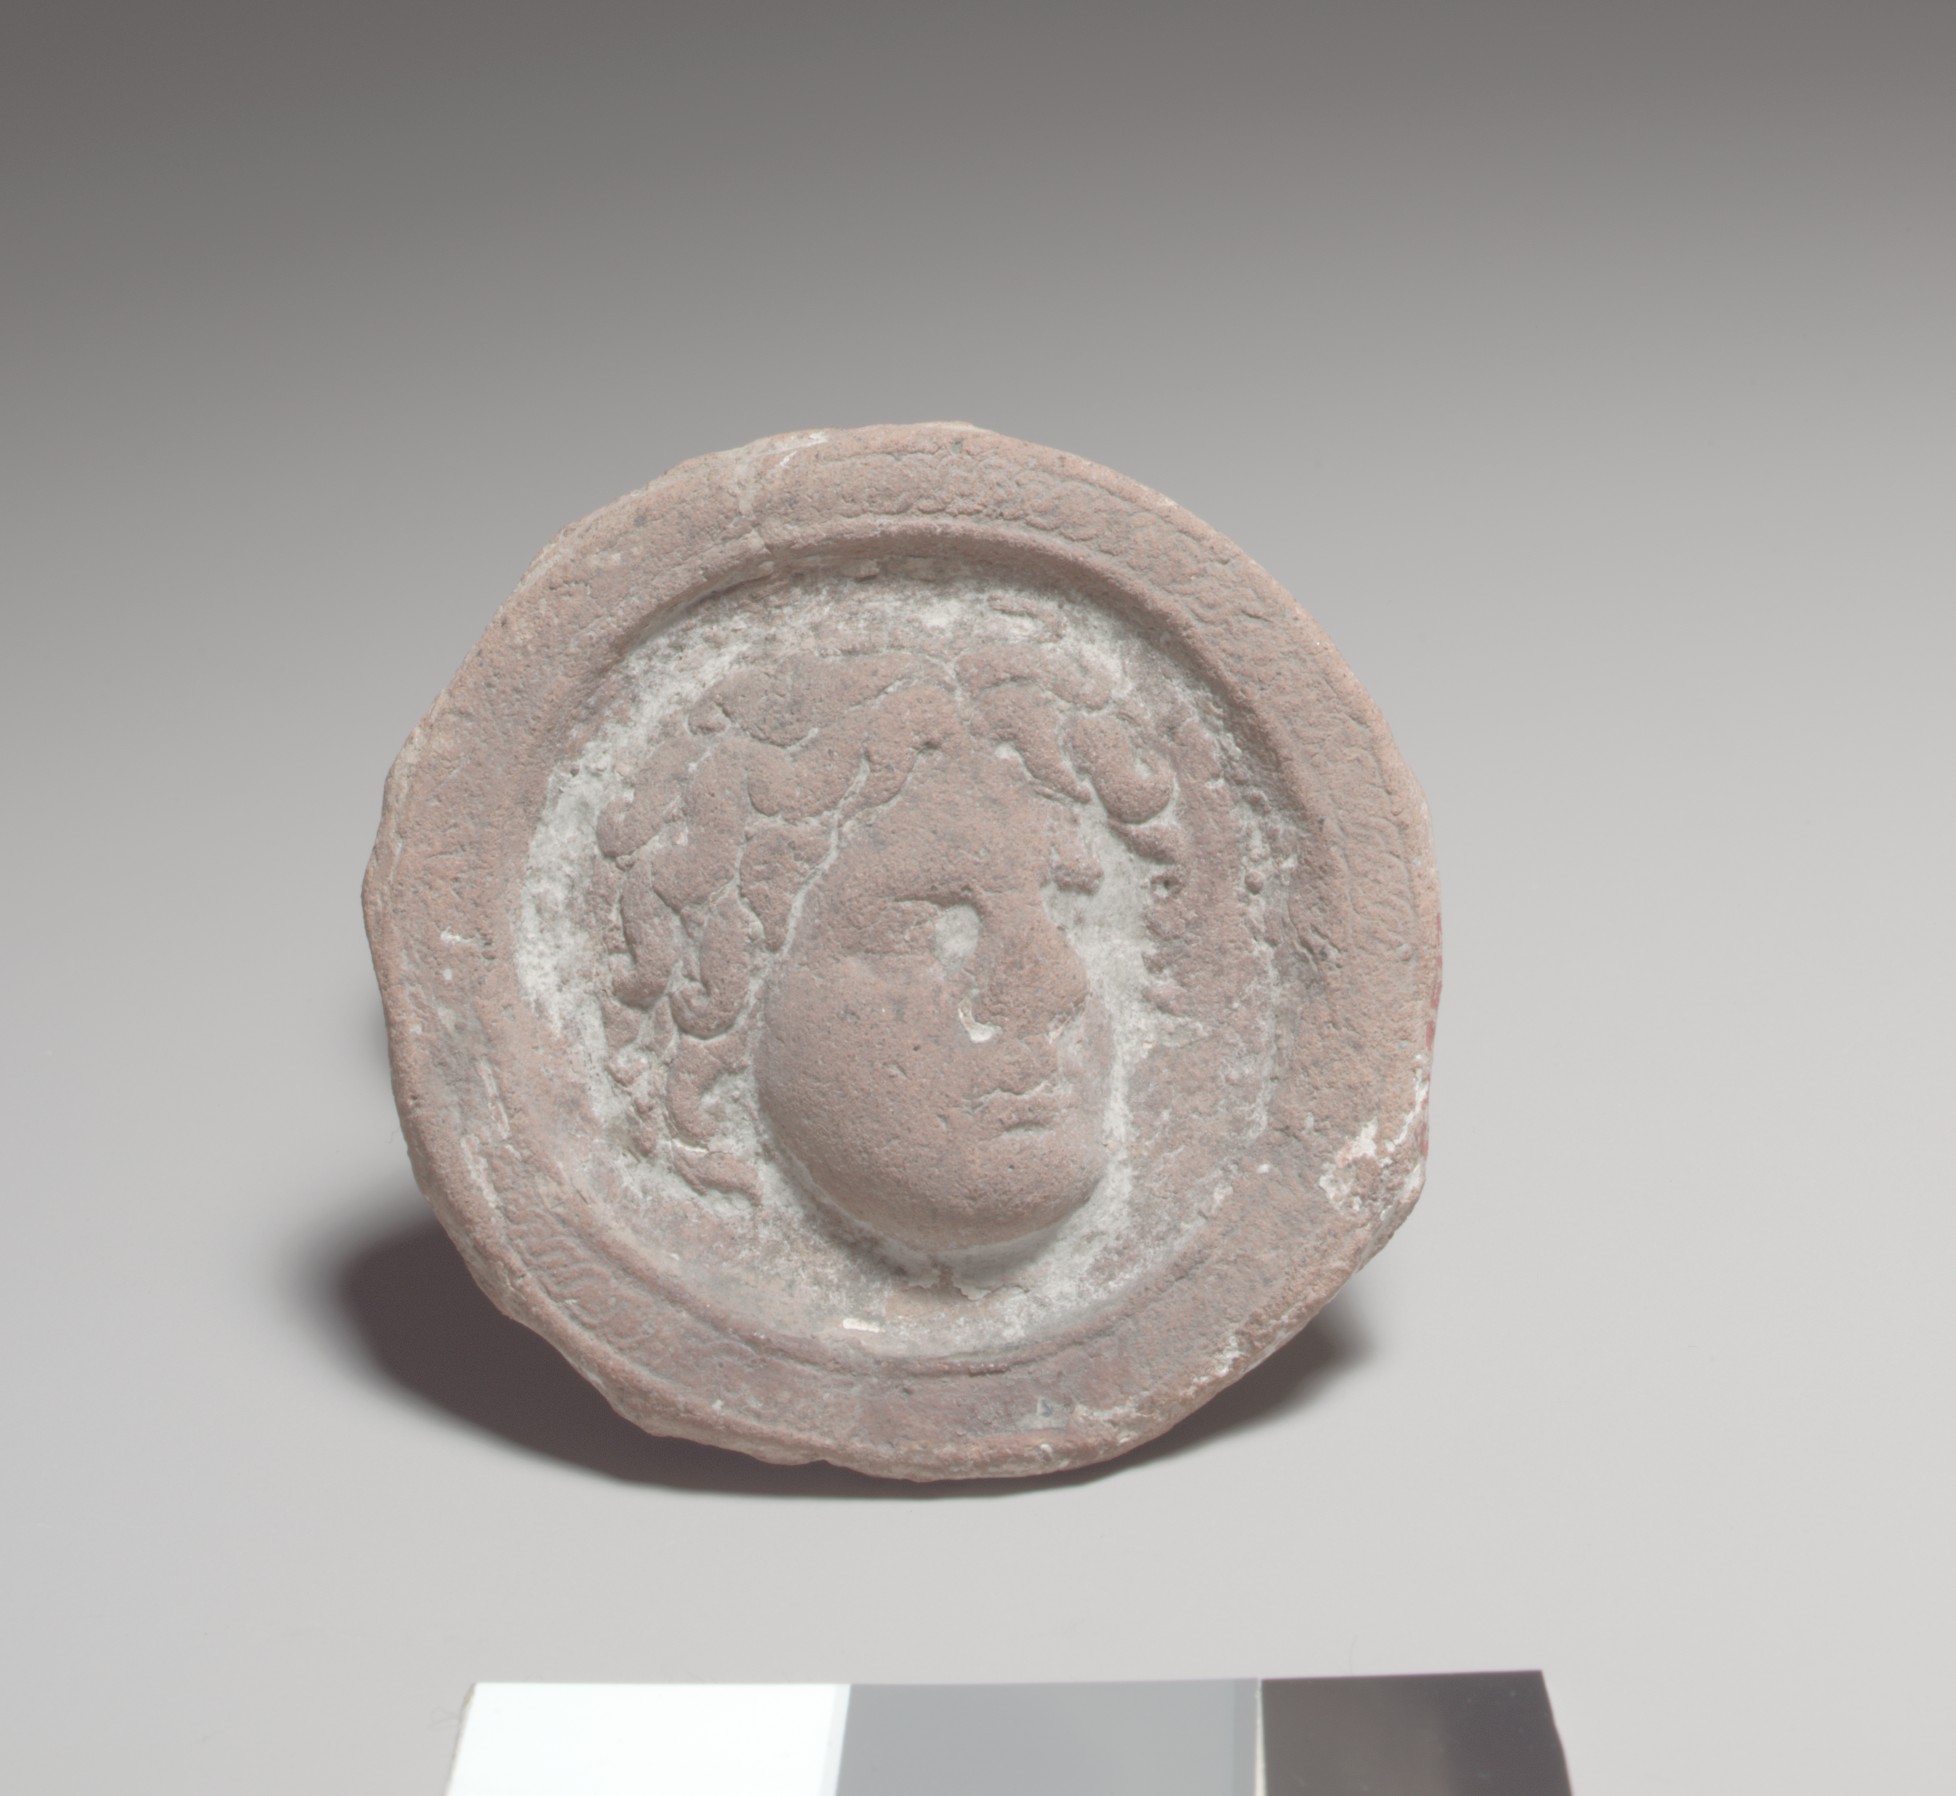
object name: roundel, medallion of a youth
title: Shield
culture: cypriot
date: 200-101 BCE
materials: terracotta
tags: shields,faces